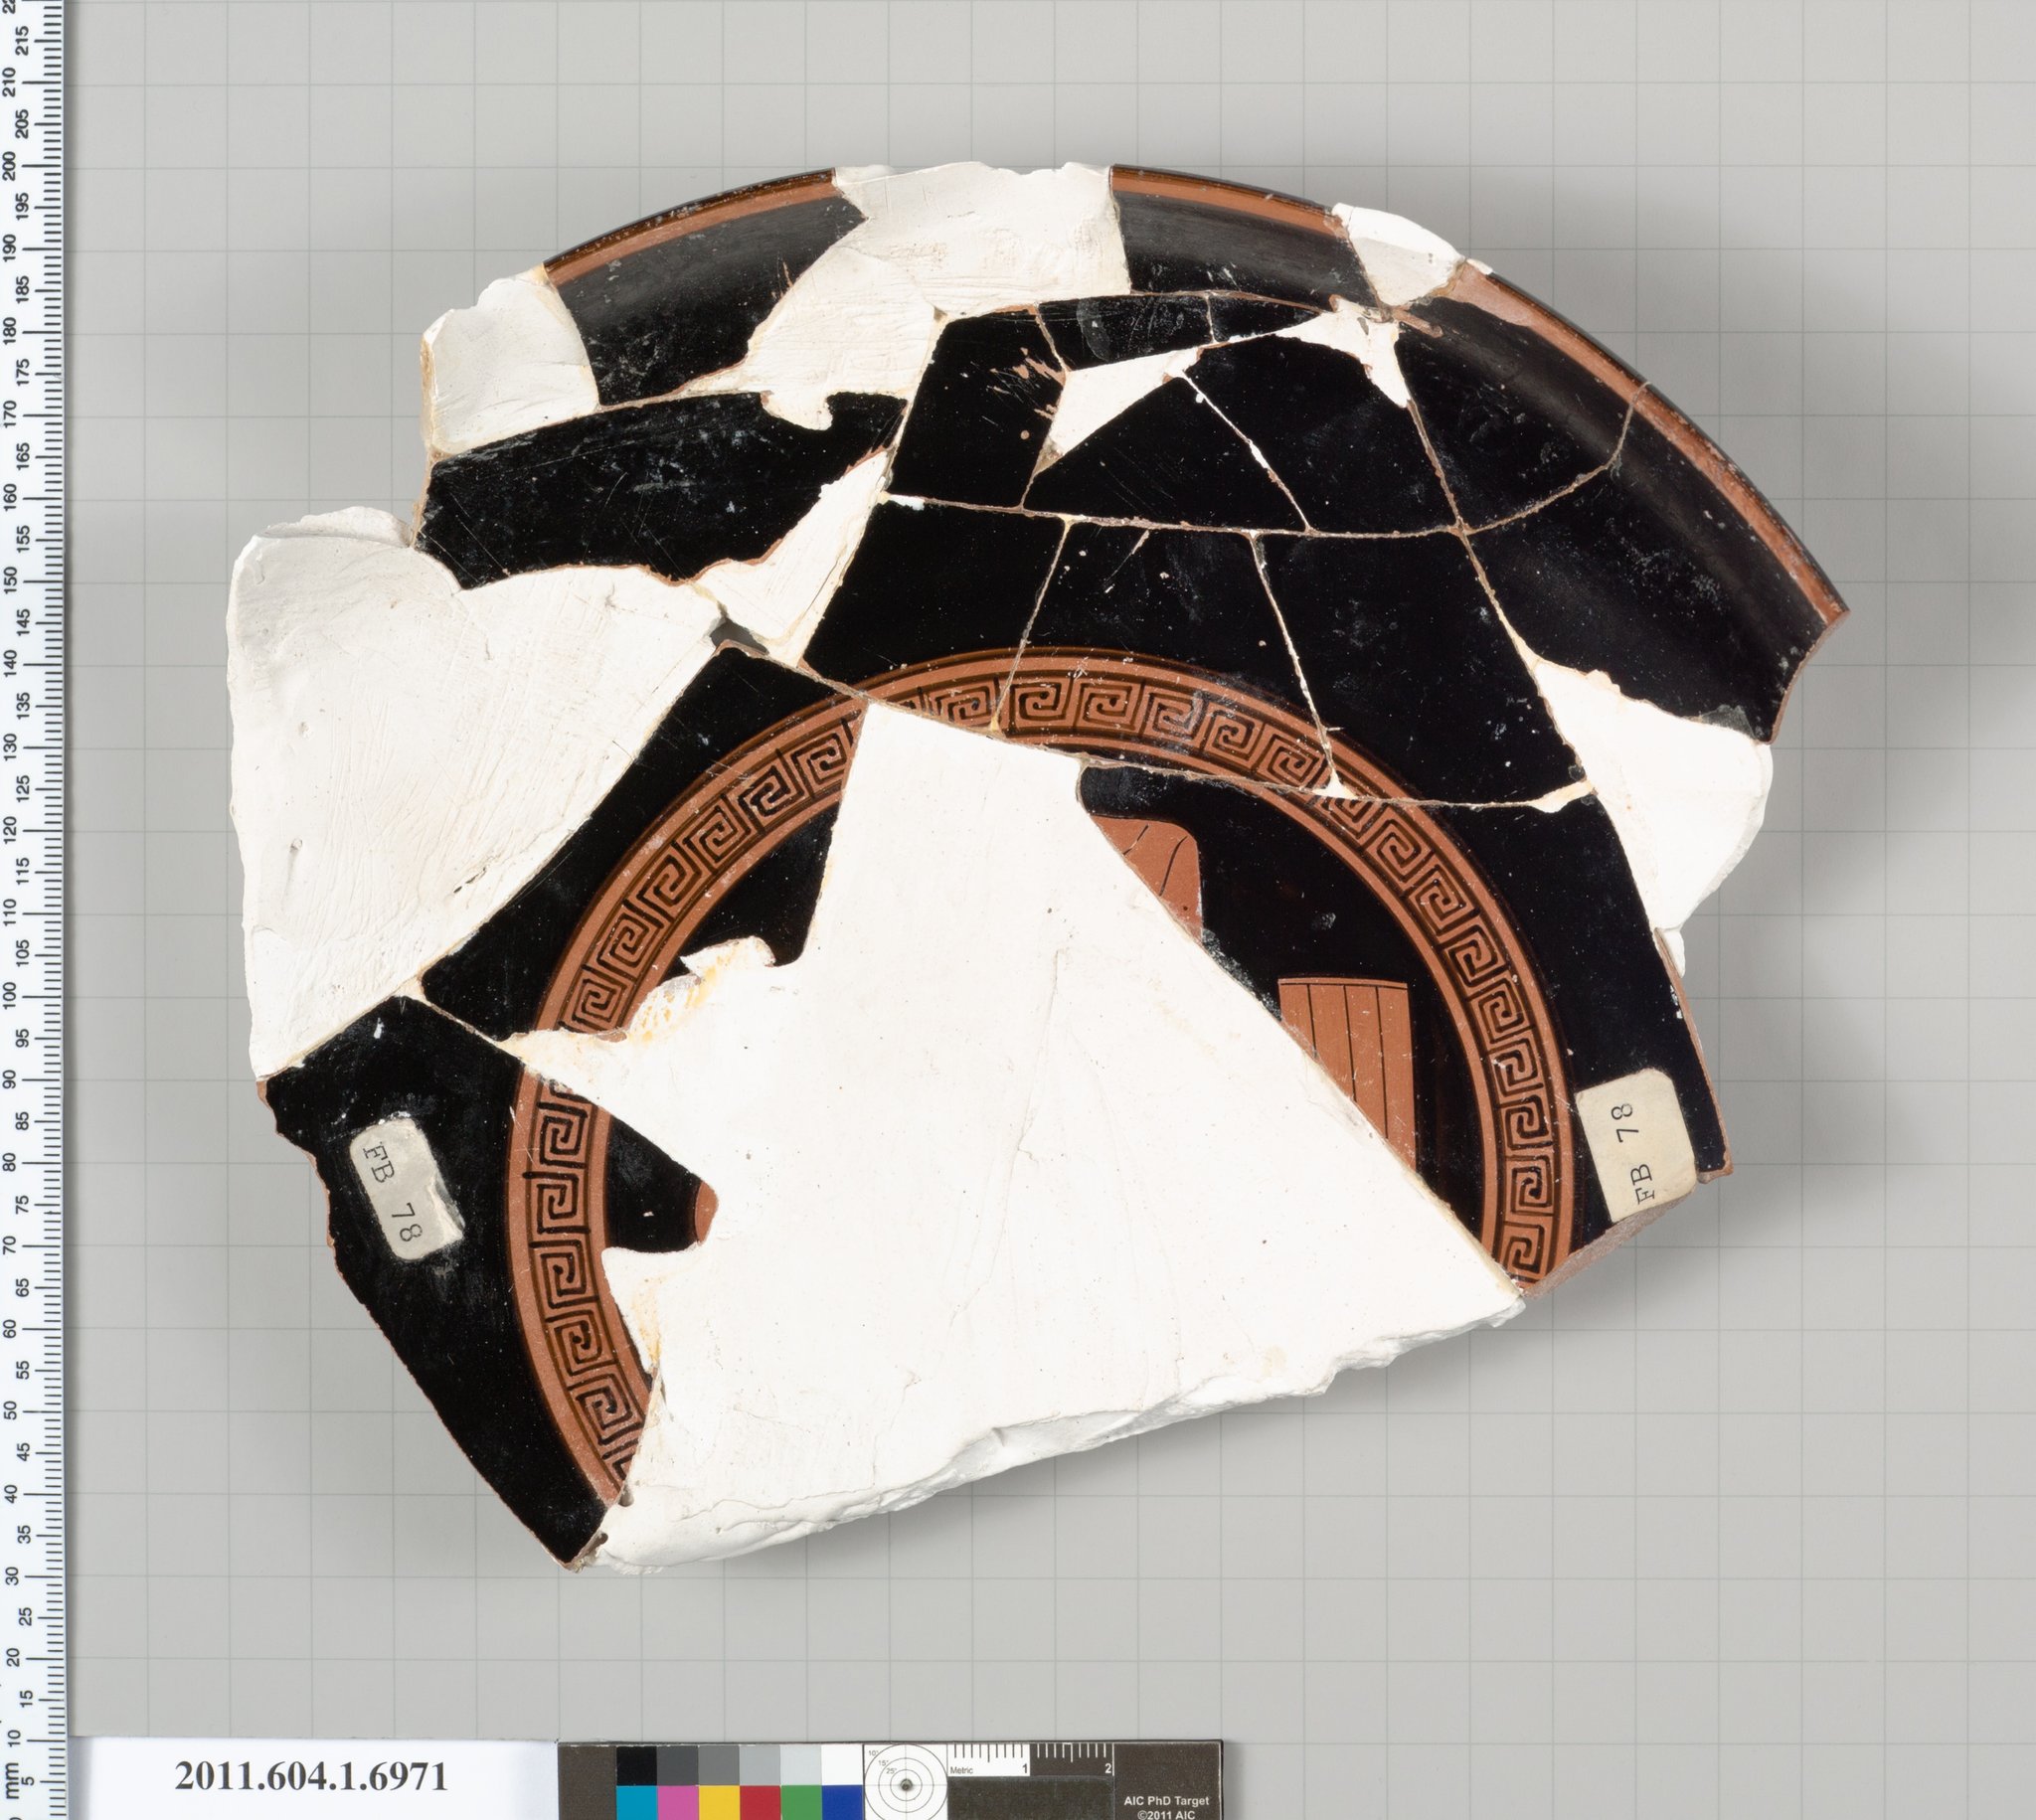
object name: kylix fragment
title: Terracotta fragment of a kylix (drinking cup)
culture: greek, attic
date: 490-470 BCE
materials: terracotta